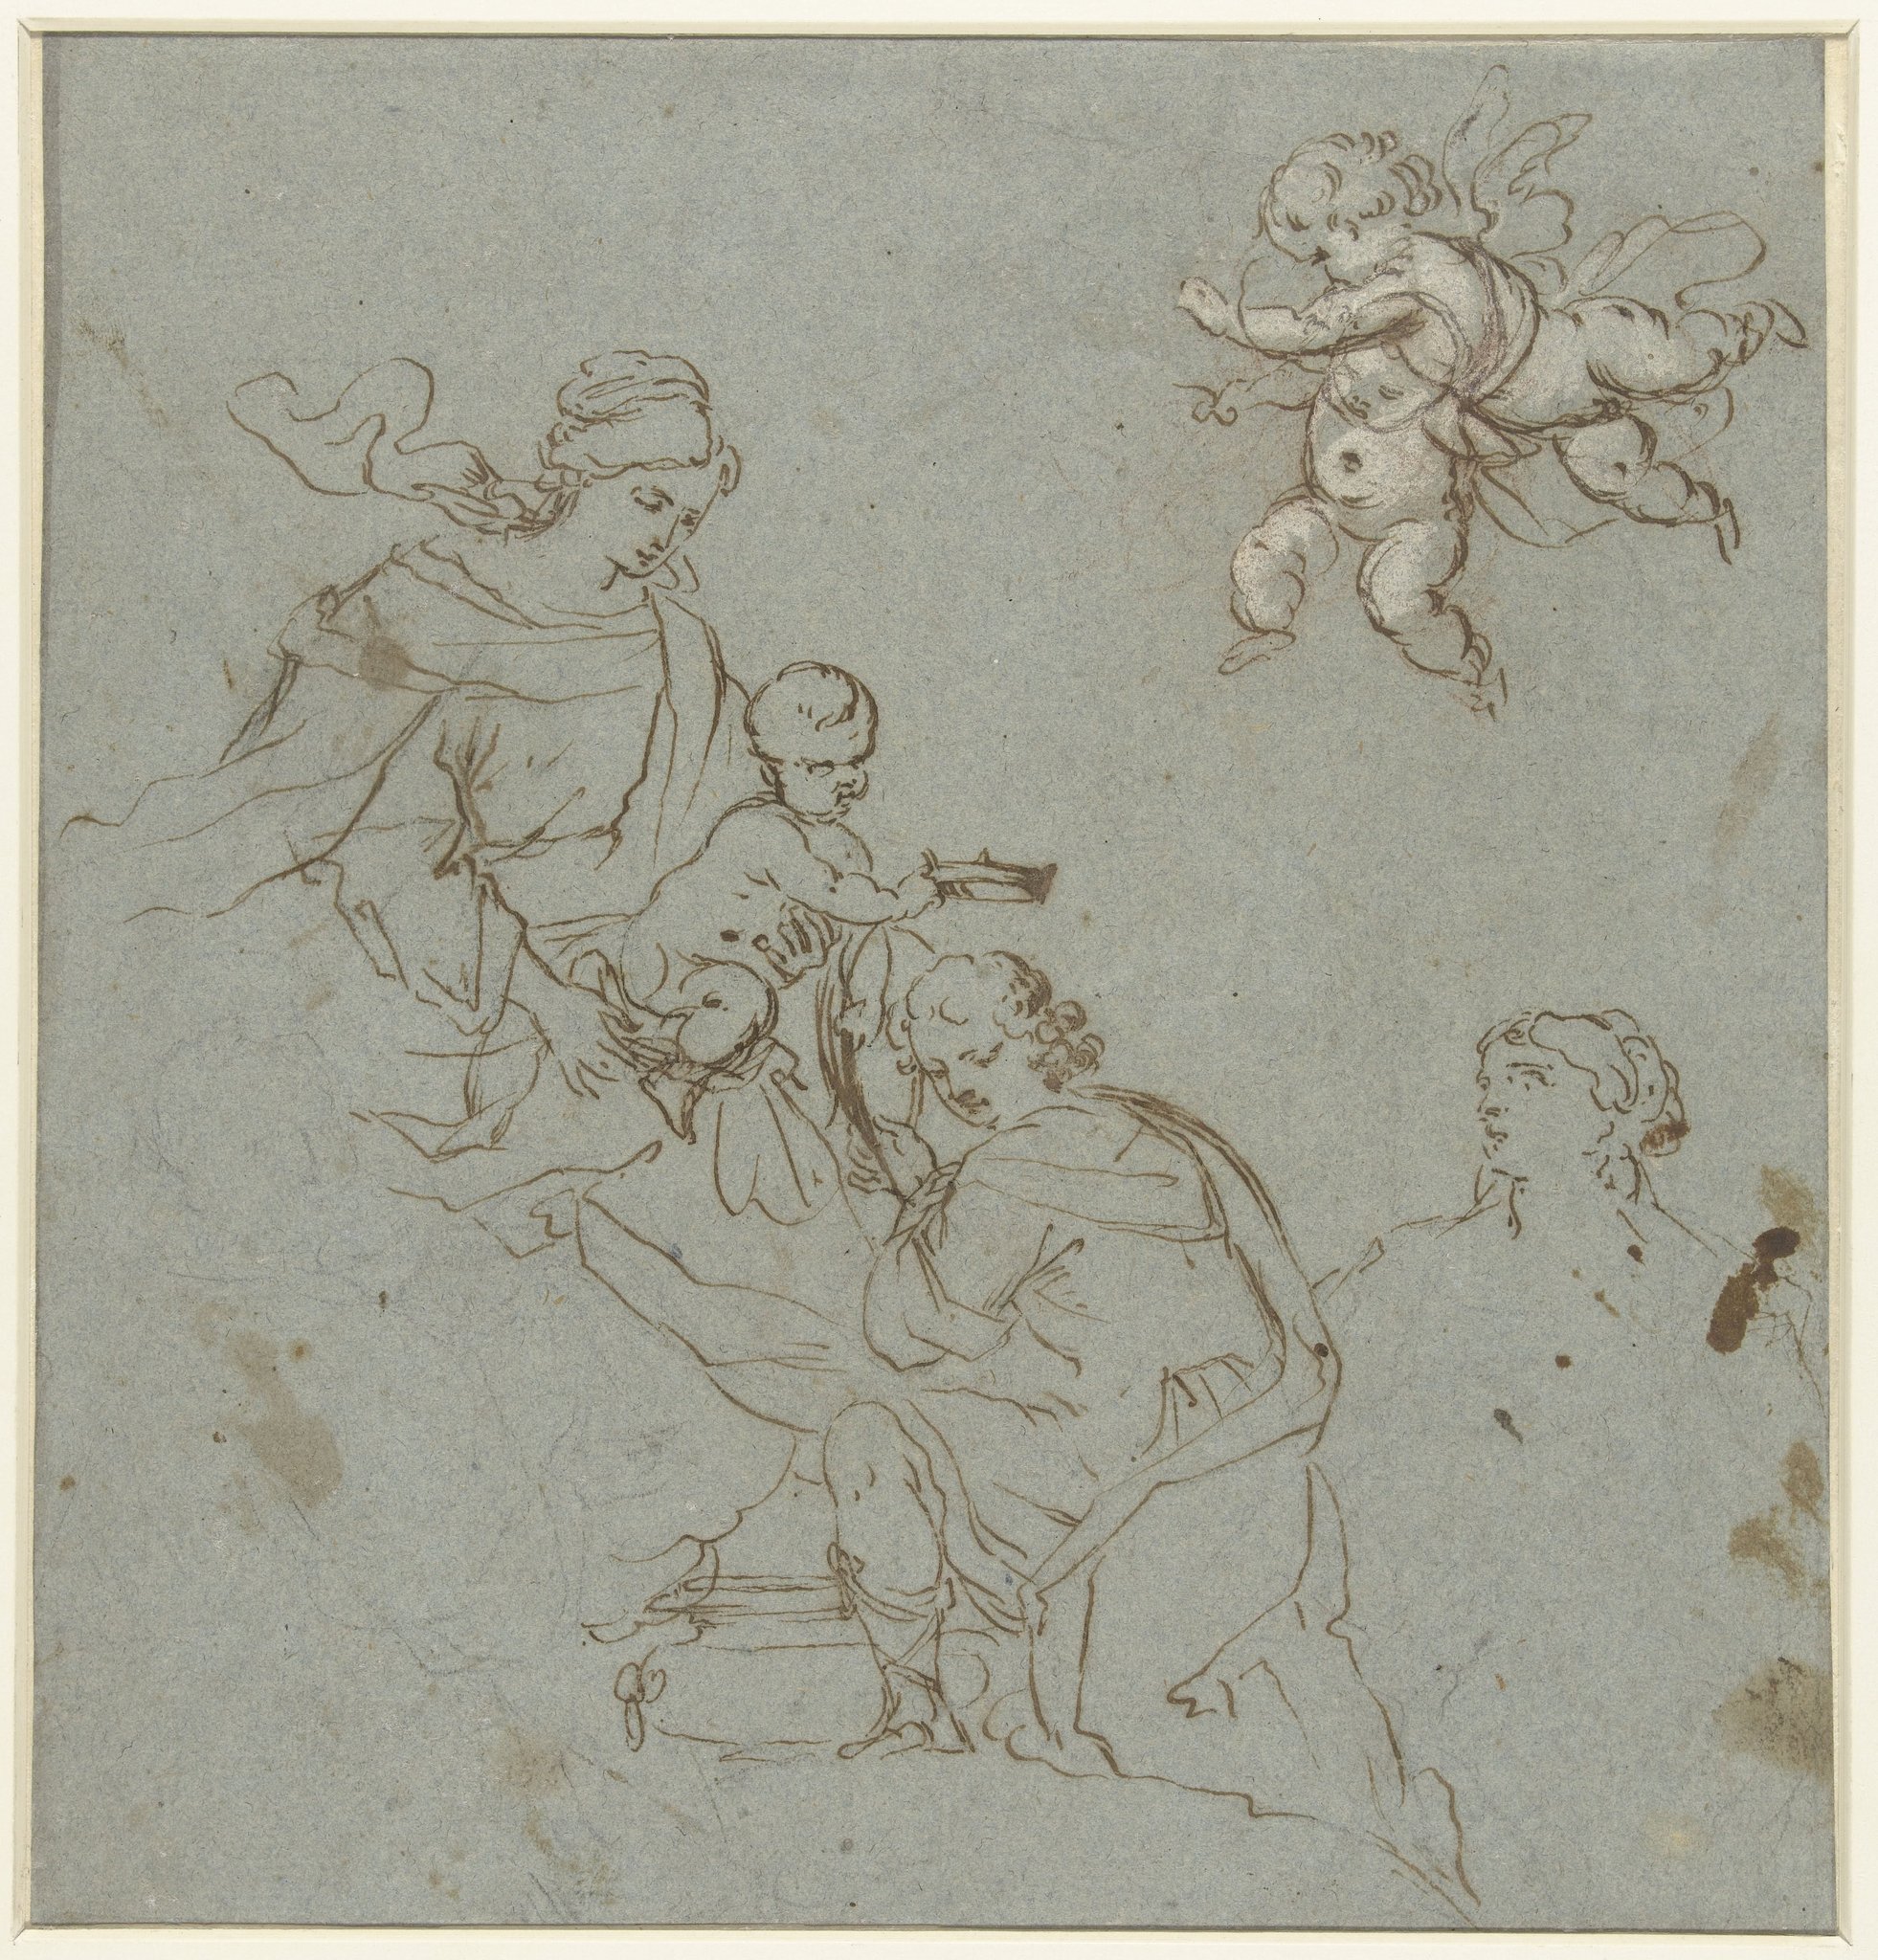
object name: drawing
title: Maria en kind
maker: Anonymous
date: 1600-1699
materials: chalk, paint, ink, paper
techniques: pen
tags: mary sitting or enthroned, the christ-child in front of her in her lap (or in front of her bosom), the soldier martyr florian of lorch; possible attributes: bucket (pitcher), lance with banner, millstone, palm-branch, shield (with cross), sword - apotheosis, glory, triumph of male saint